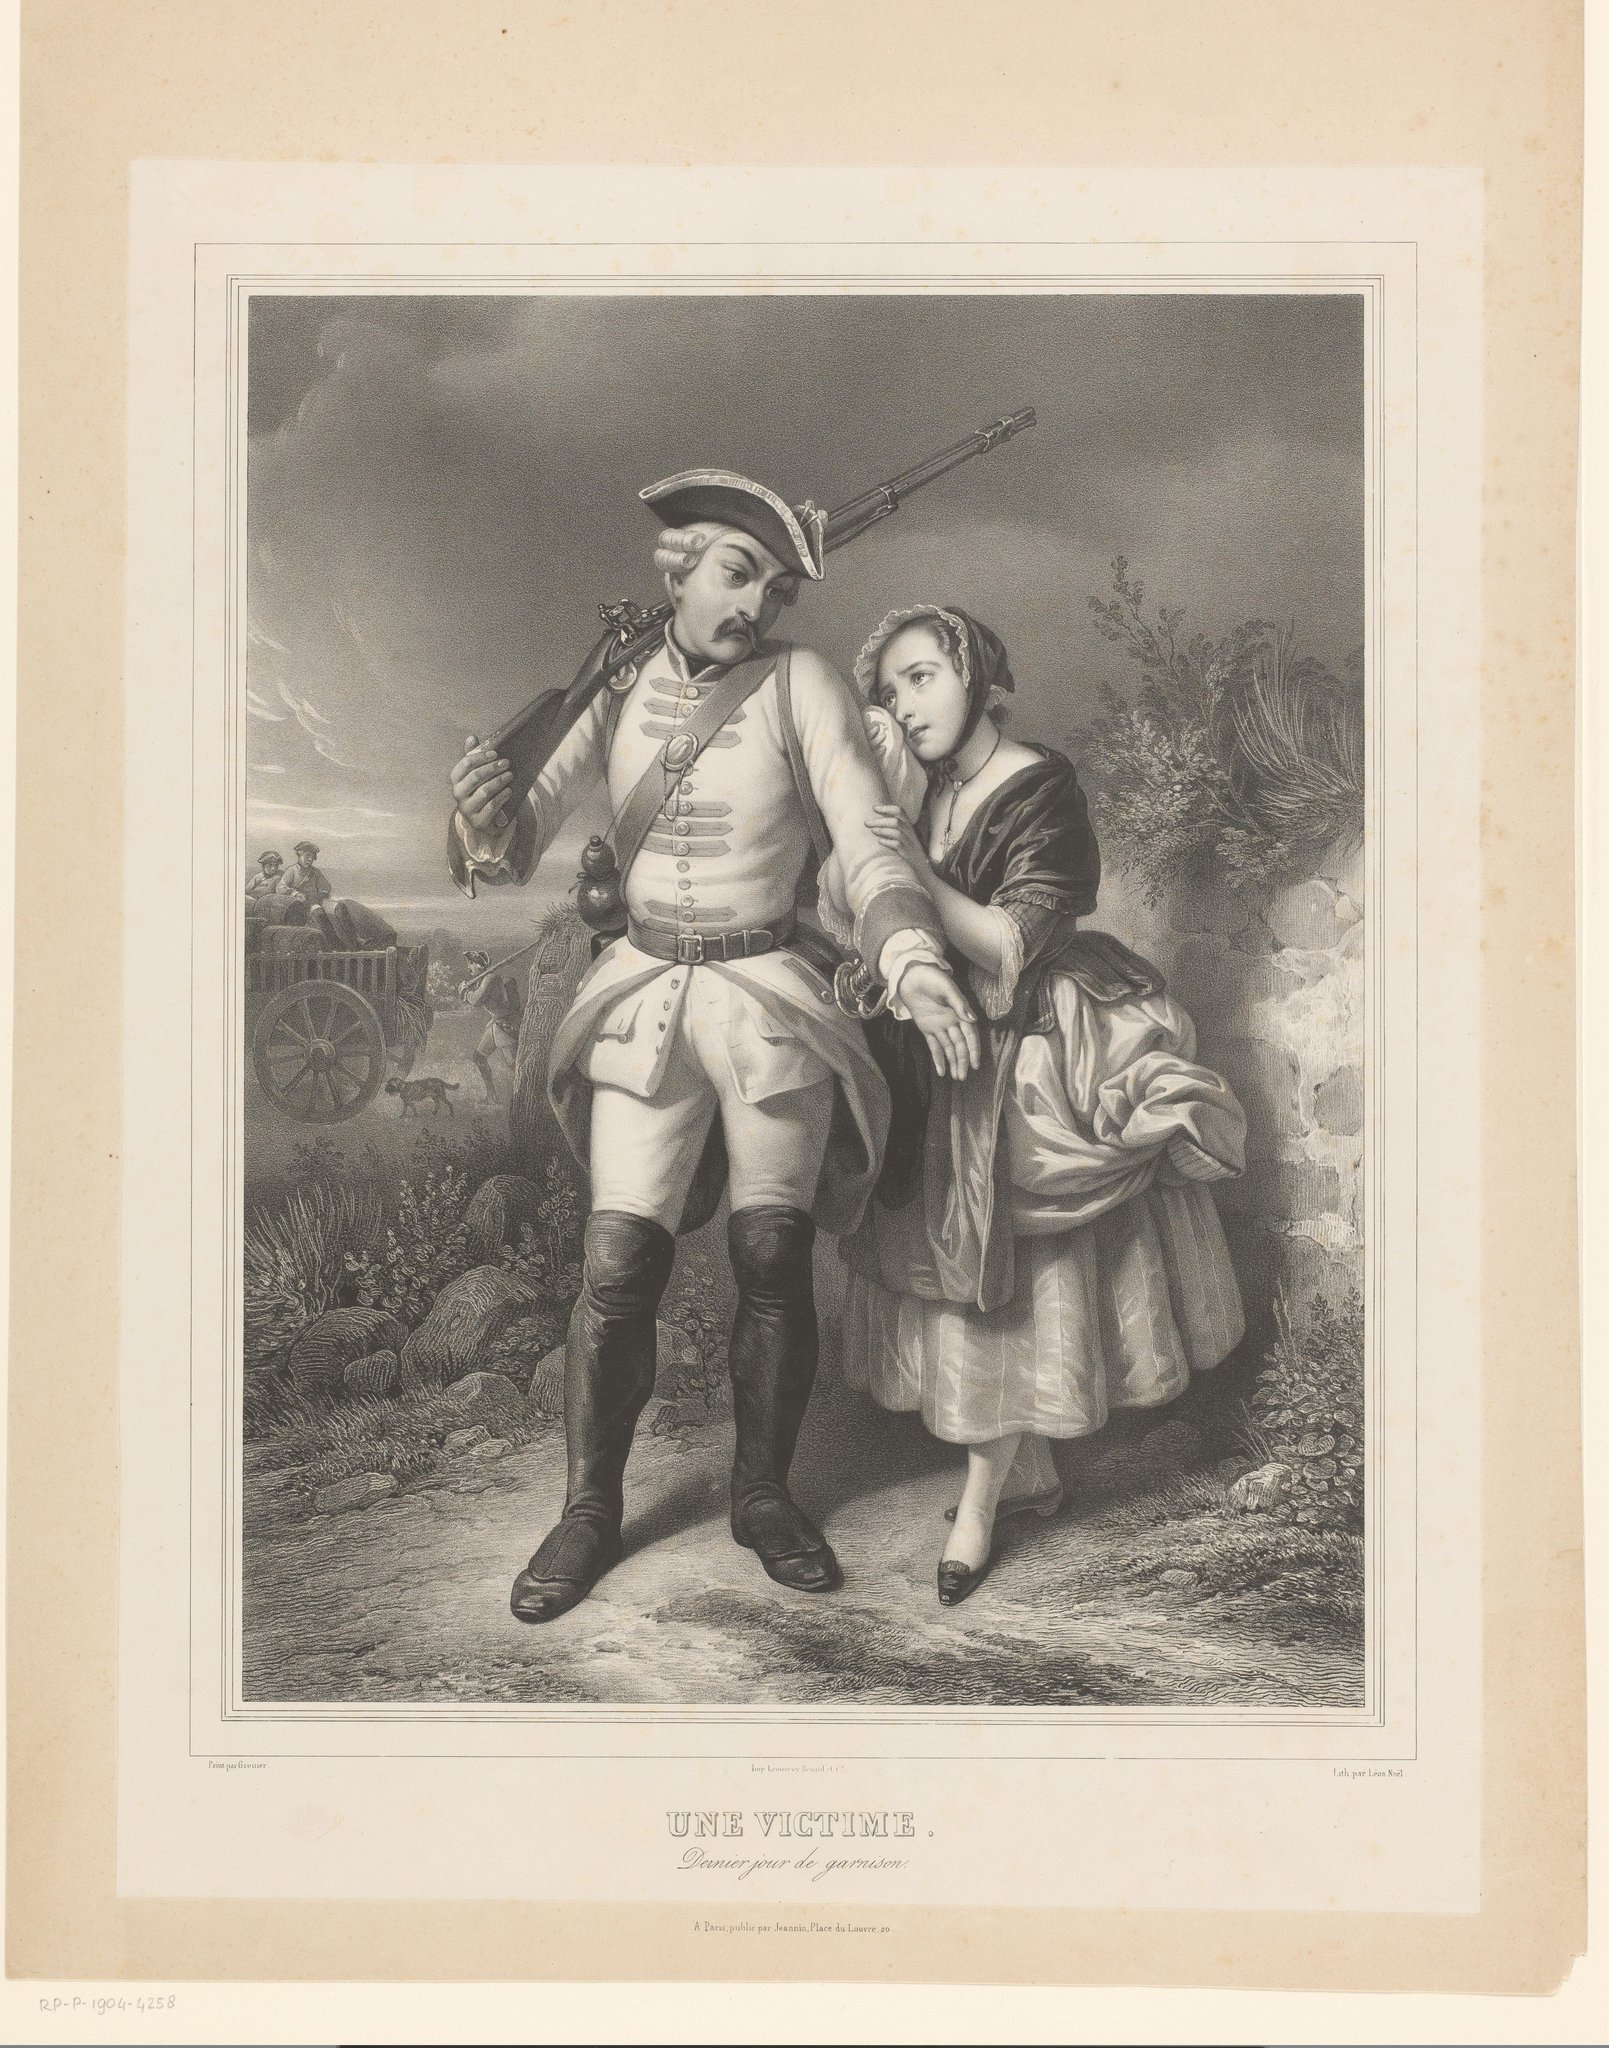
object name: print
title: Jonge vrouw neemt met verdriet afscheid van man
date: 1837-1843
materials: paper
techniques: lithograph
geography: paris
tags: tears, the soldier; the soldier's life, (military) uniforms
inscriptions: check stamp: Lugt 1397c, collector's mark: Lugt 2228